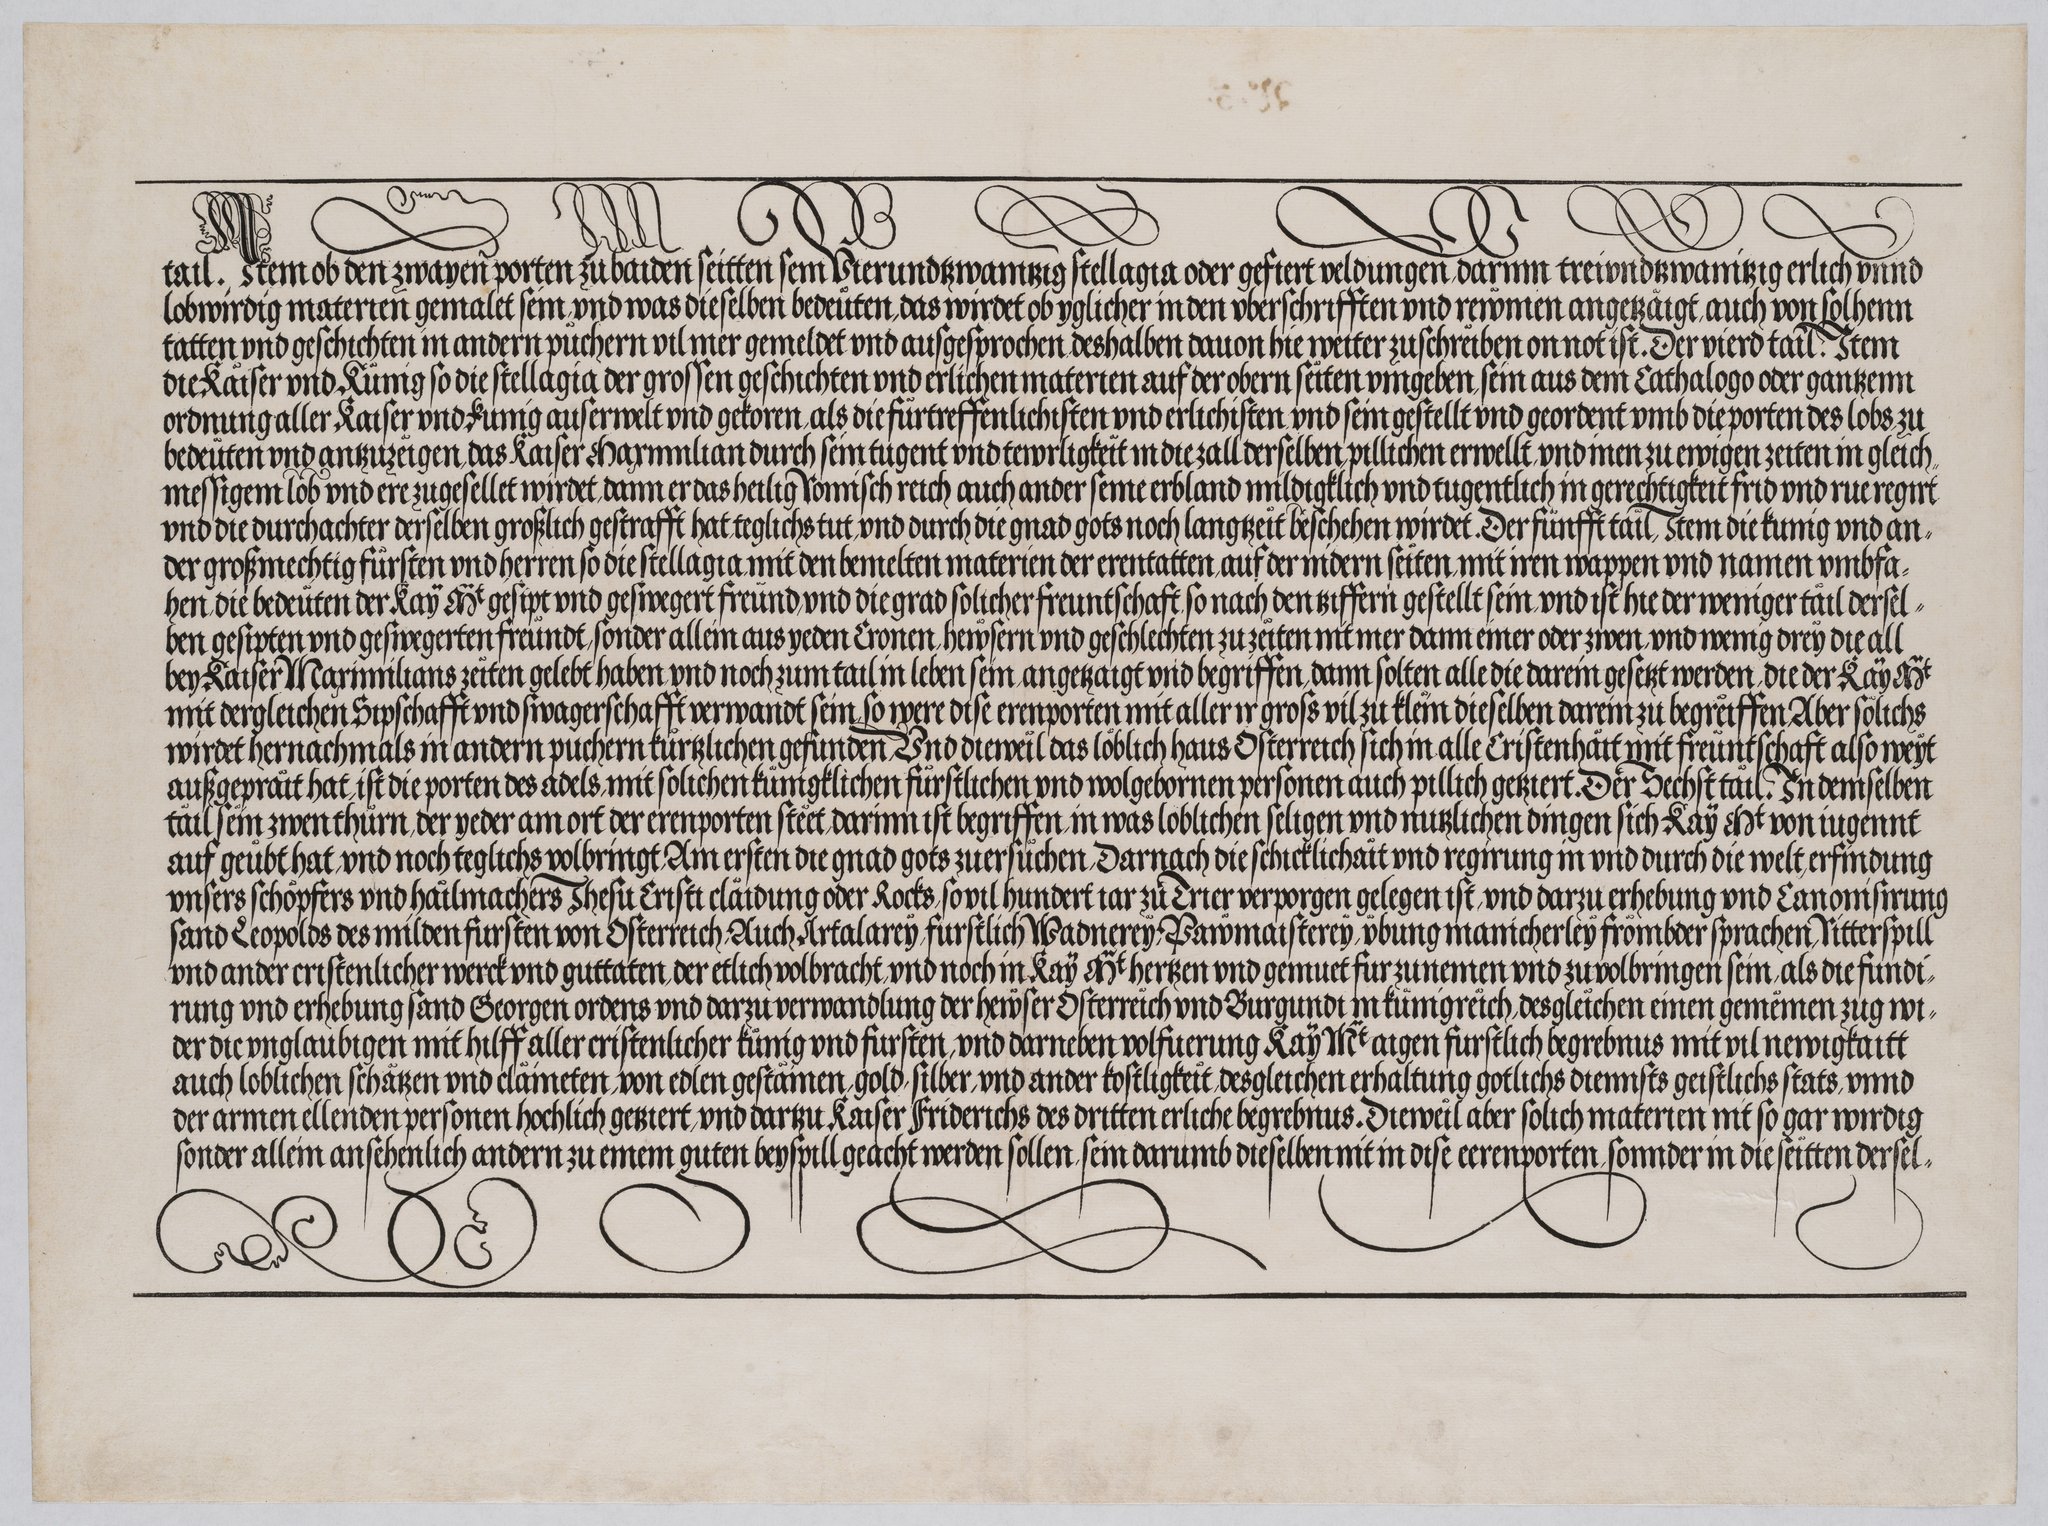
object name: print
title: Explanatory Text, Part III,from the Arch of Honor, proof, dated 1515, printed 1517-18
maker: hieronymus andreae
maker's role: block cutter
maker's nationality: german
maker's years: 1525-1556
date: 1515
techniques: letterpress, woodcut